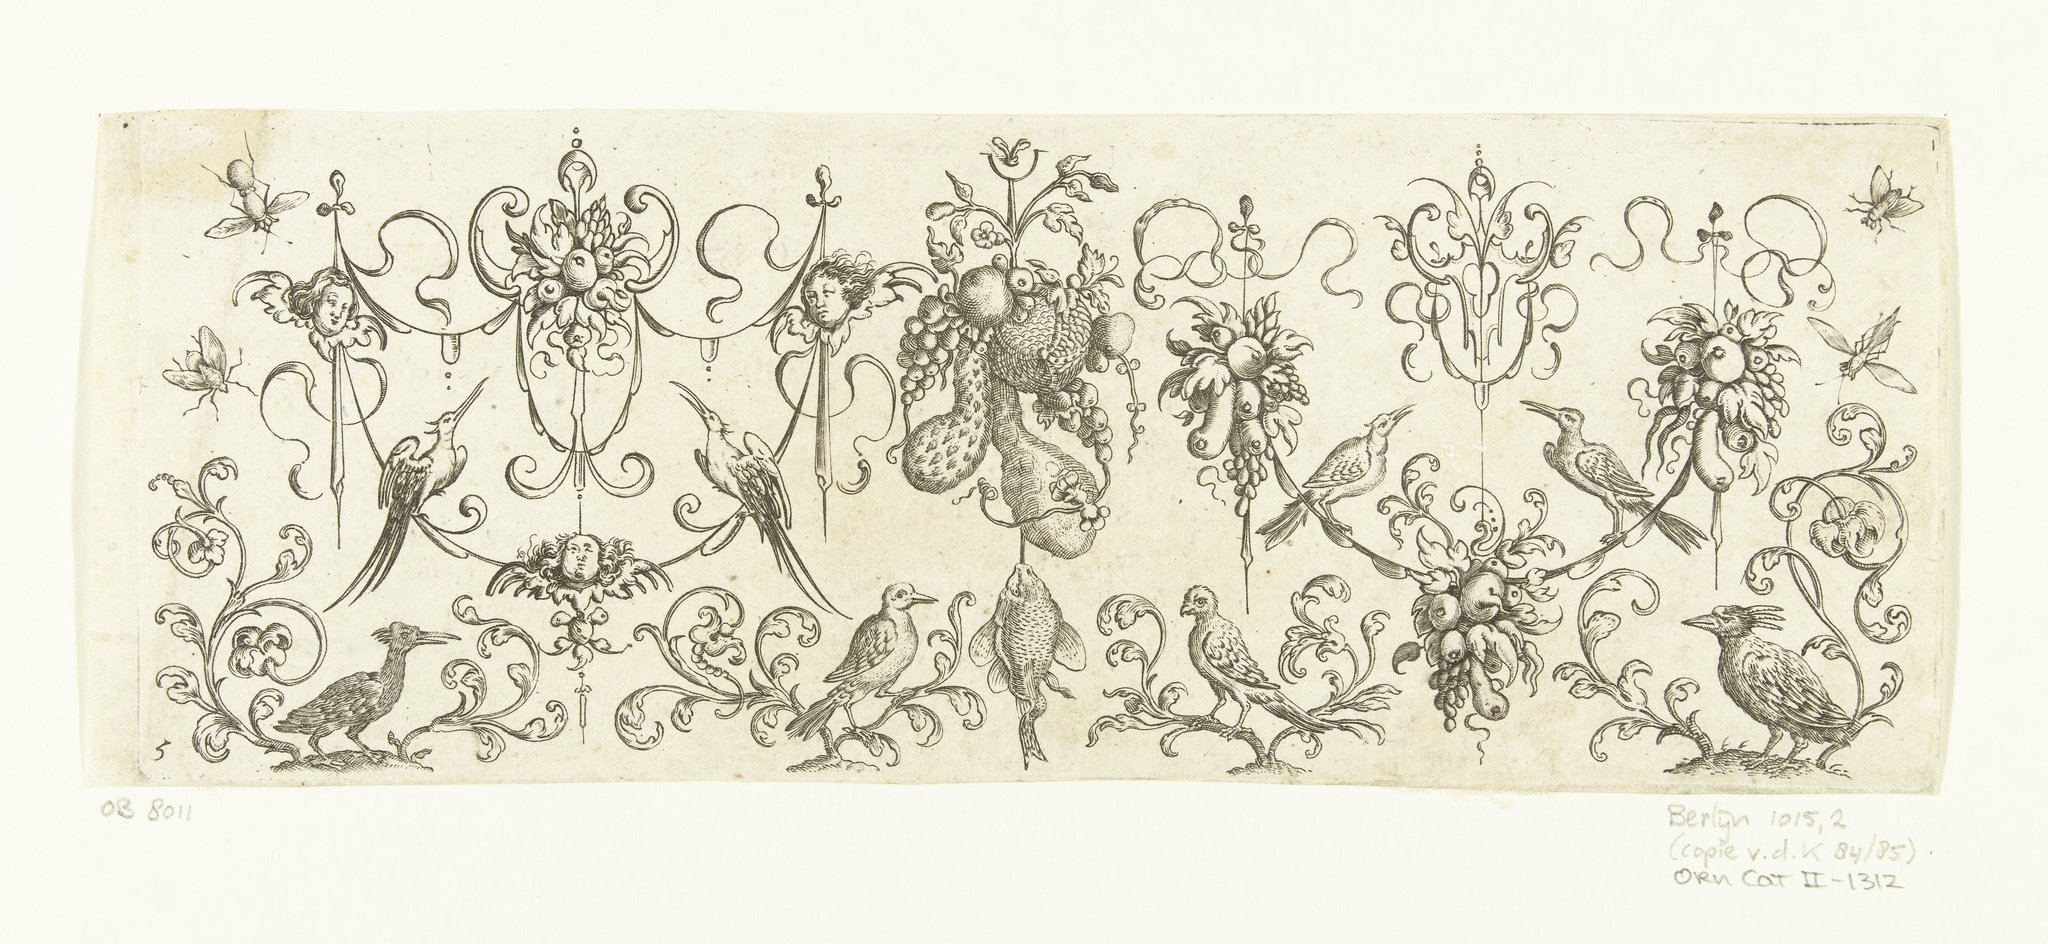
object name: ornament print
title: Spitsen en randen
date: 1611-1656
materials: paper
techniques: engraving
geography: france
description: Tegenzijdige kopie naar prenten (blad 13 en 14) uit de serie Somige Eenvoldige Vruchten en Spitsen. Uit serie bladen waarop telkens twee motieven naast elkaar te zien zijn, aangevuld met vogels, insecten, bloempotten en soms een ornamentele rand met ranken en dieren.